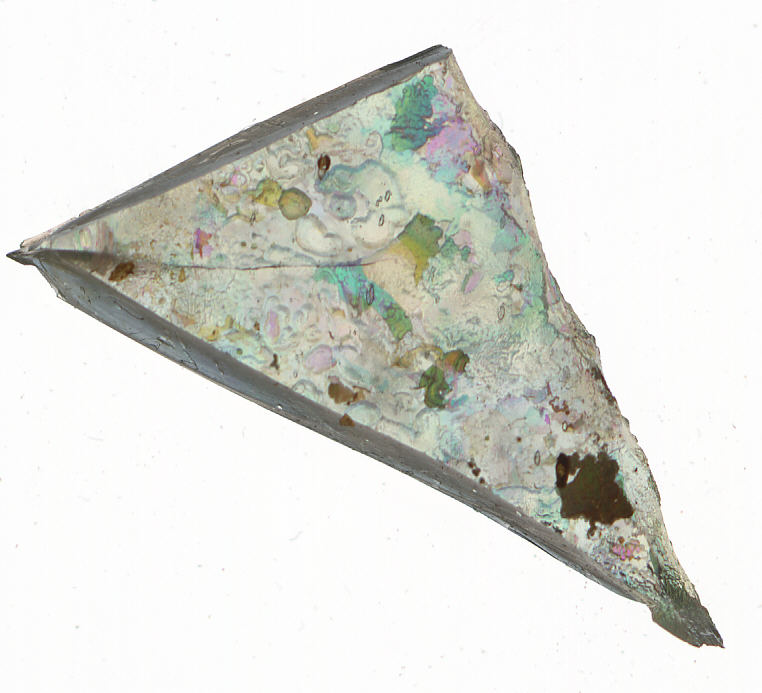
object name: fragment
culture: crusader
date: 1201-1300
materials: glass